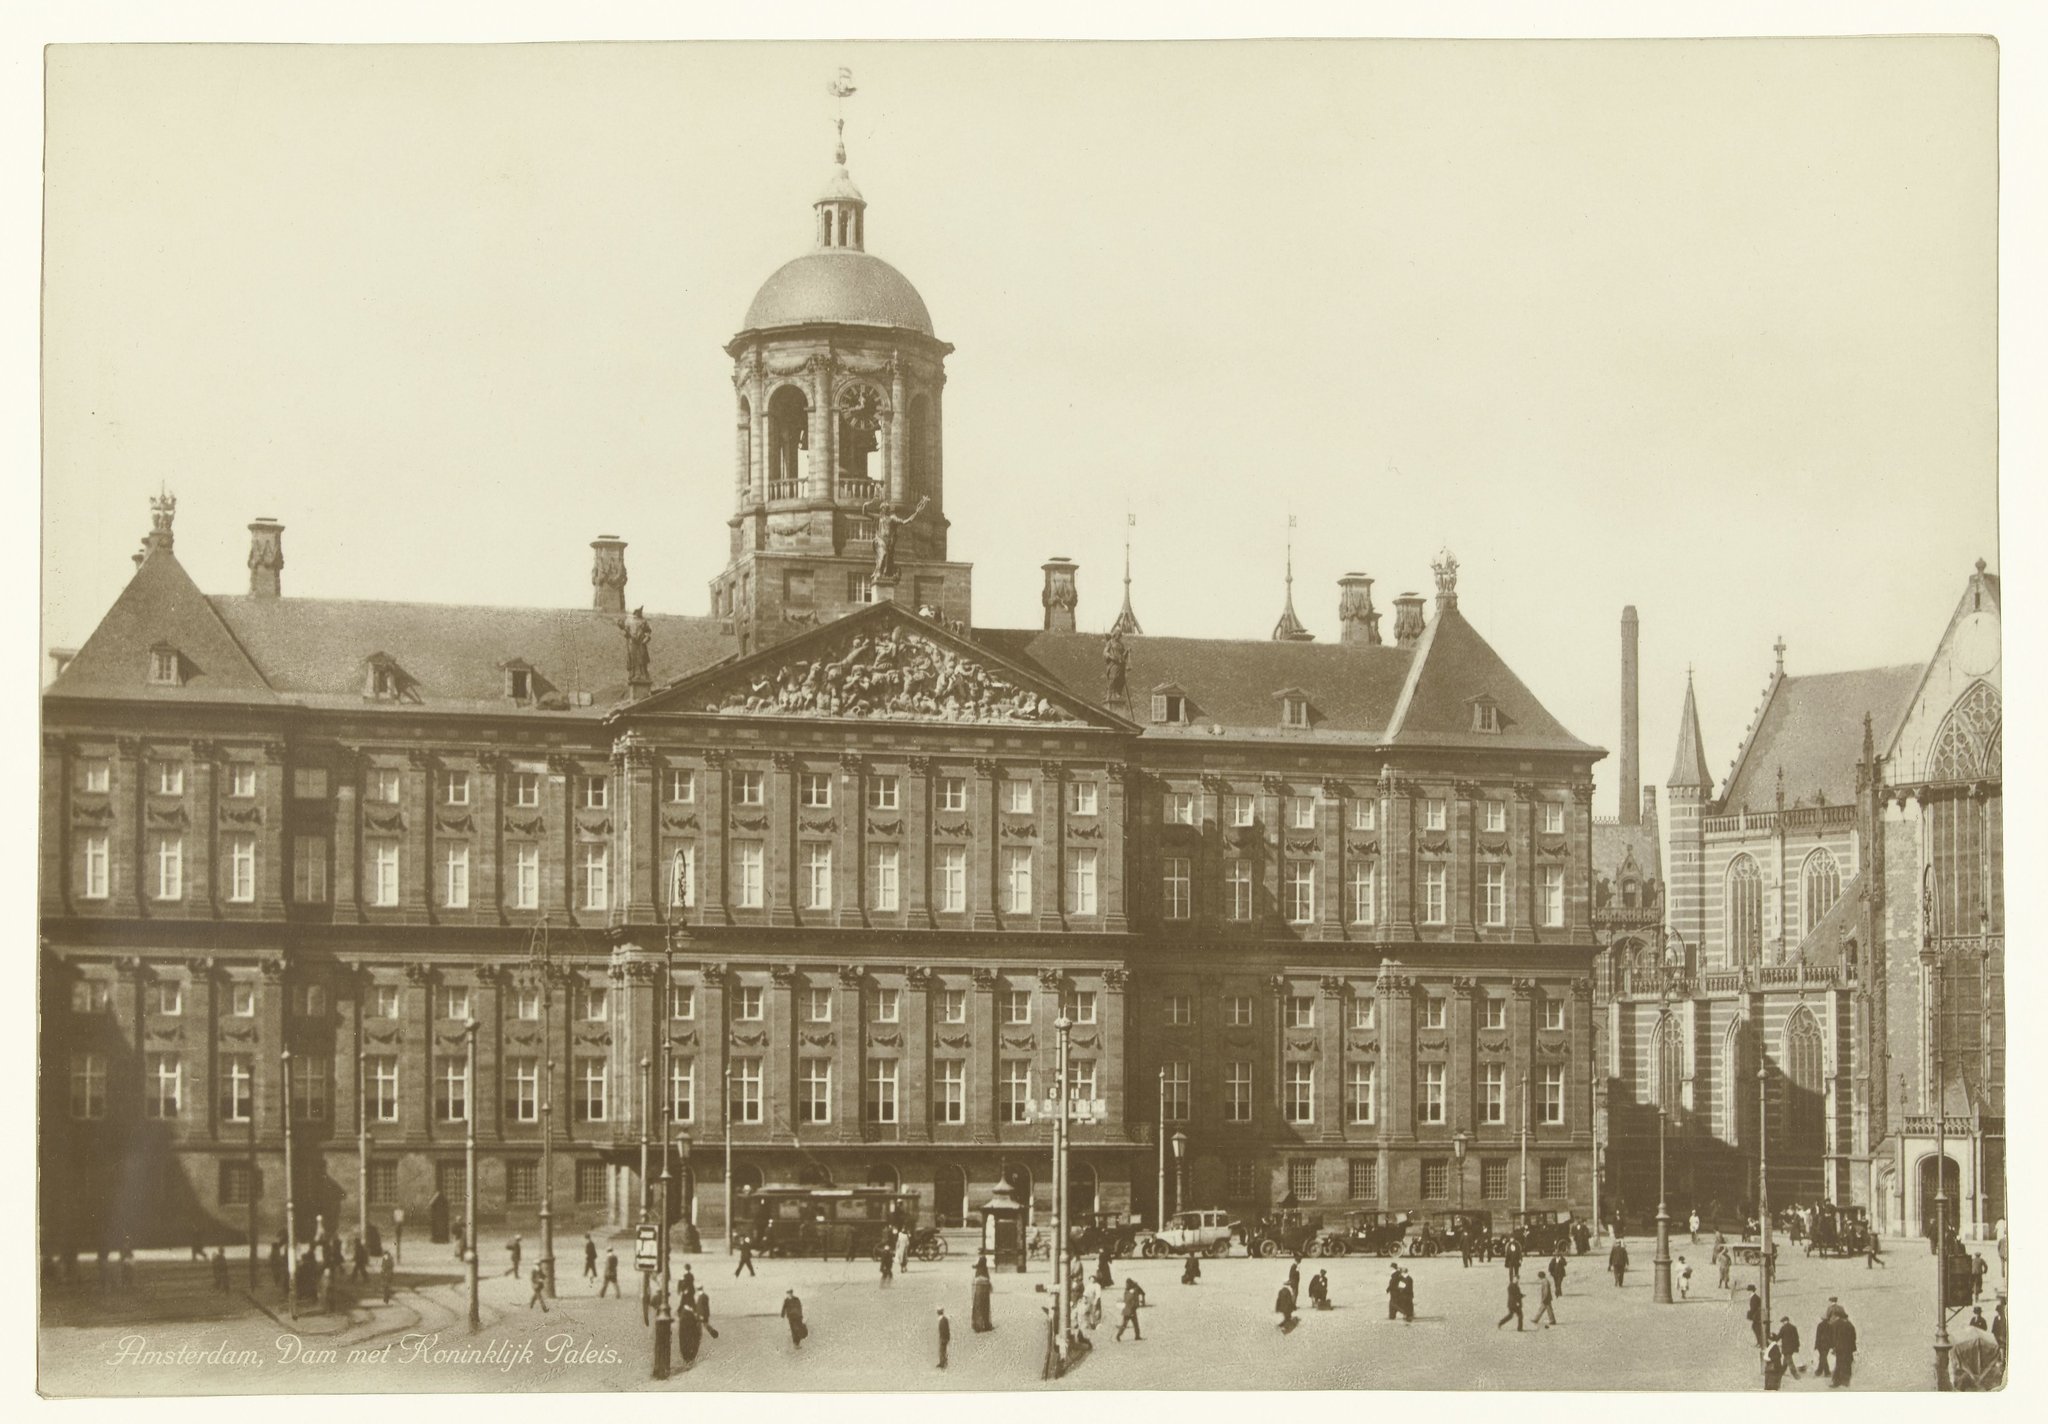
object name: photograph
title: Amsterdam, Dam met koninklijk paleis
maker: Anonymous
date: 1920-1940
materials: paper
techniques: carbon print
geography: netherlands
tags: square, place, circus, etc., palace, royal palace of amsterdam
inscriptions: title: ‘Amsterdam, Dam met koninklijk paleis’